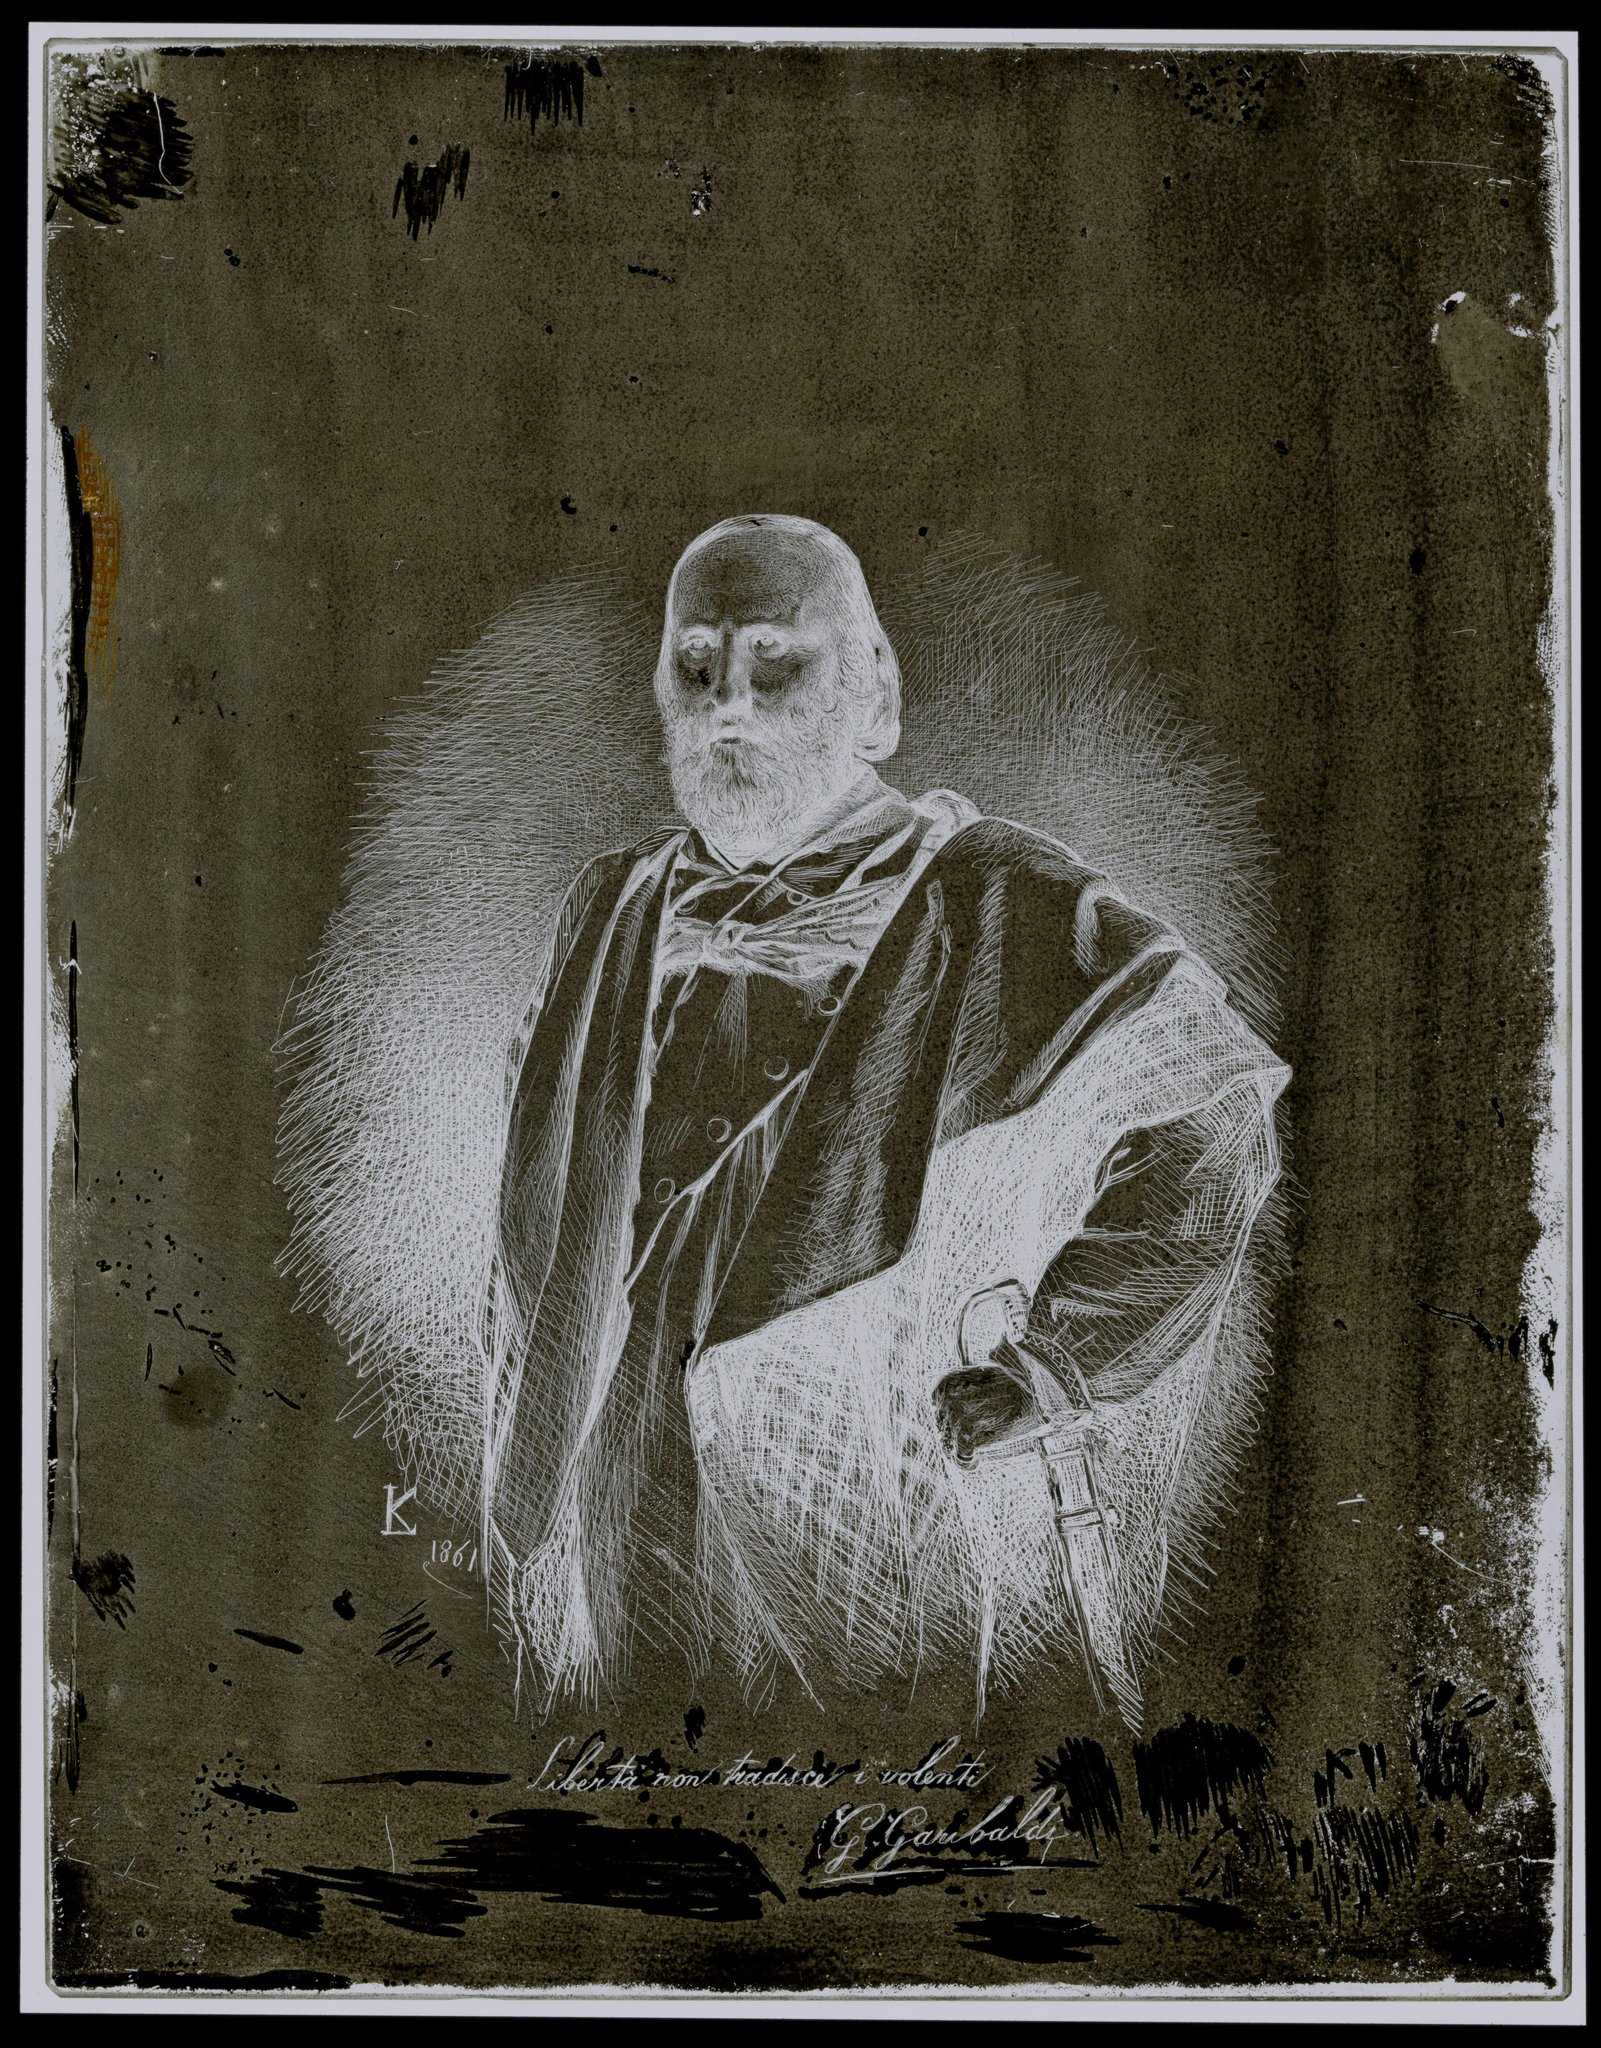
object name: glasnegatief, glasplaatnegatief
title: Reproductie van een gefotografeerd portret van Giuseppe Garibaldi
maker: laurens lodewijk kleijn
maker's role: draughtsman, painter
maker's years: 1826-1909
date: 1861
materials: glass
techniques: scoring, collodion process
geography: italy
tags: historical persons (portraits and scenes from the life)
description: Onderdeel van een groep glasnegatieven uit de nalatenschap van de schilder Laurens Lodewijk Kleijn, met stillevens, portretten, zelfportretten en kunstreproducties.